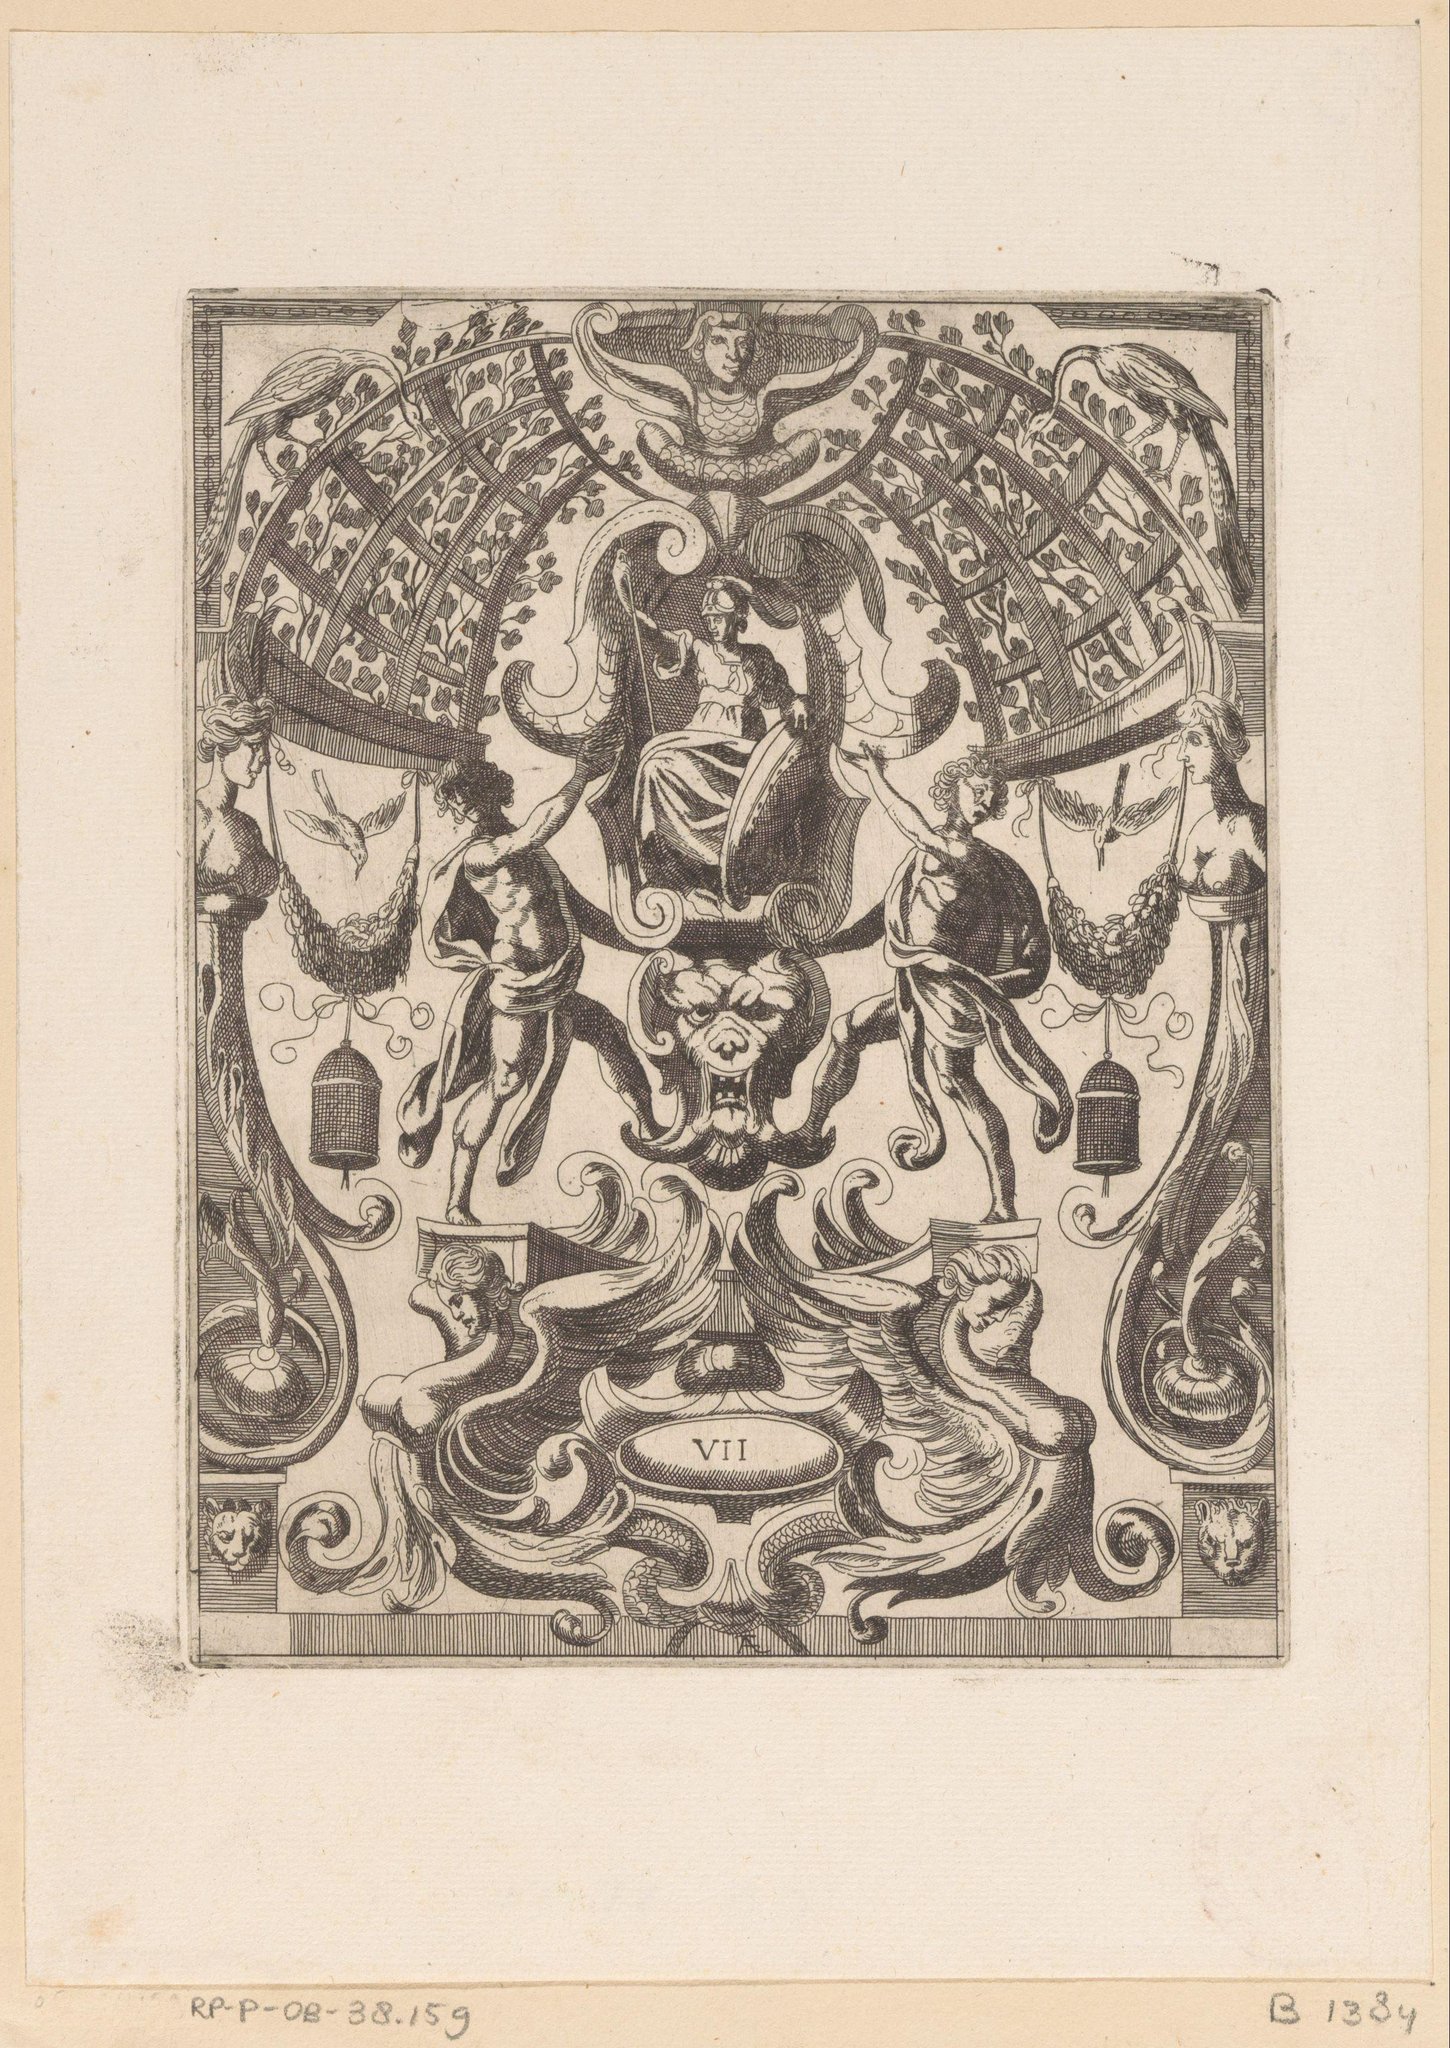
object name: print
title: Groteske ornamenten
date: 1624-1679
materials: paper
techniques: etching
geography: antwerp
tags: fabulous beings with wings - aa - female human figure, ornaments ~ art, (story of) minerva (pallas, athena)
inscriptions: collector's mark: Lugt 240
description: Deze prent maakt deel uit van een reeks van tien prenten met groteske ornamenten. Deze prenten zijn kopieën uitgegeven door Frans van den Wijngaerde naar een reeks prenten door Antonio Tempesta met de titel 'Esemplare del disegno in gratia dei Principianti nell'arte della pitura et scultura'. De originele serie was uitgegeven door Giovanni Orlandi in 1602.